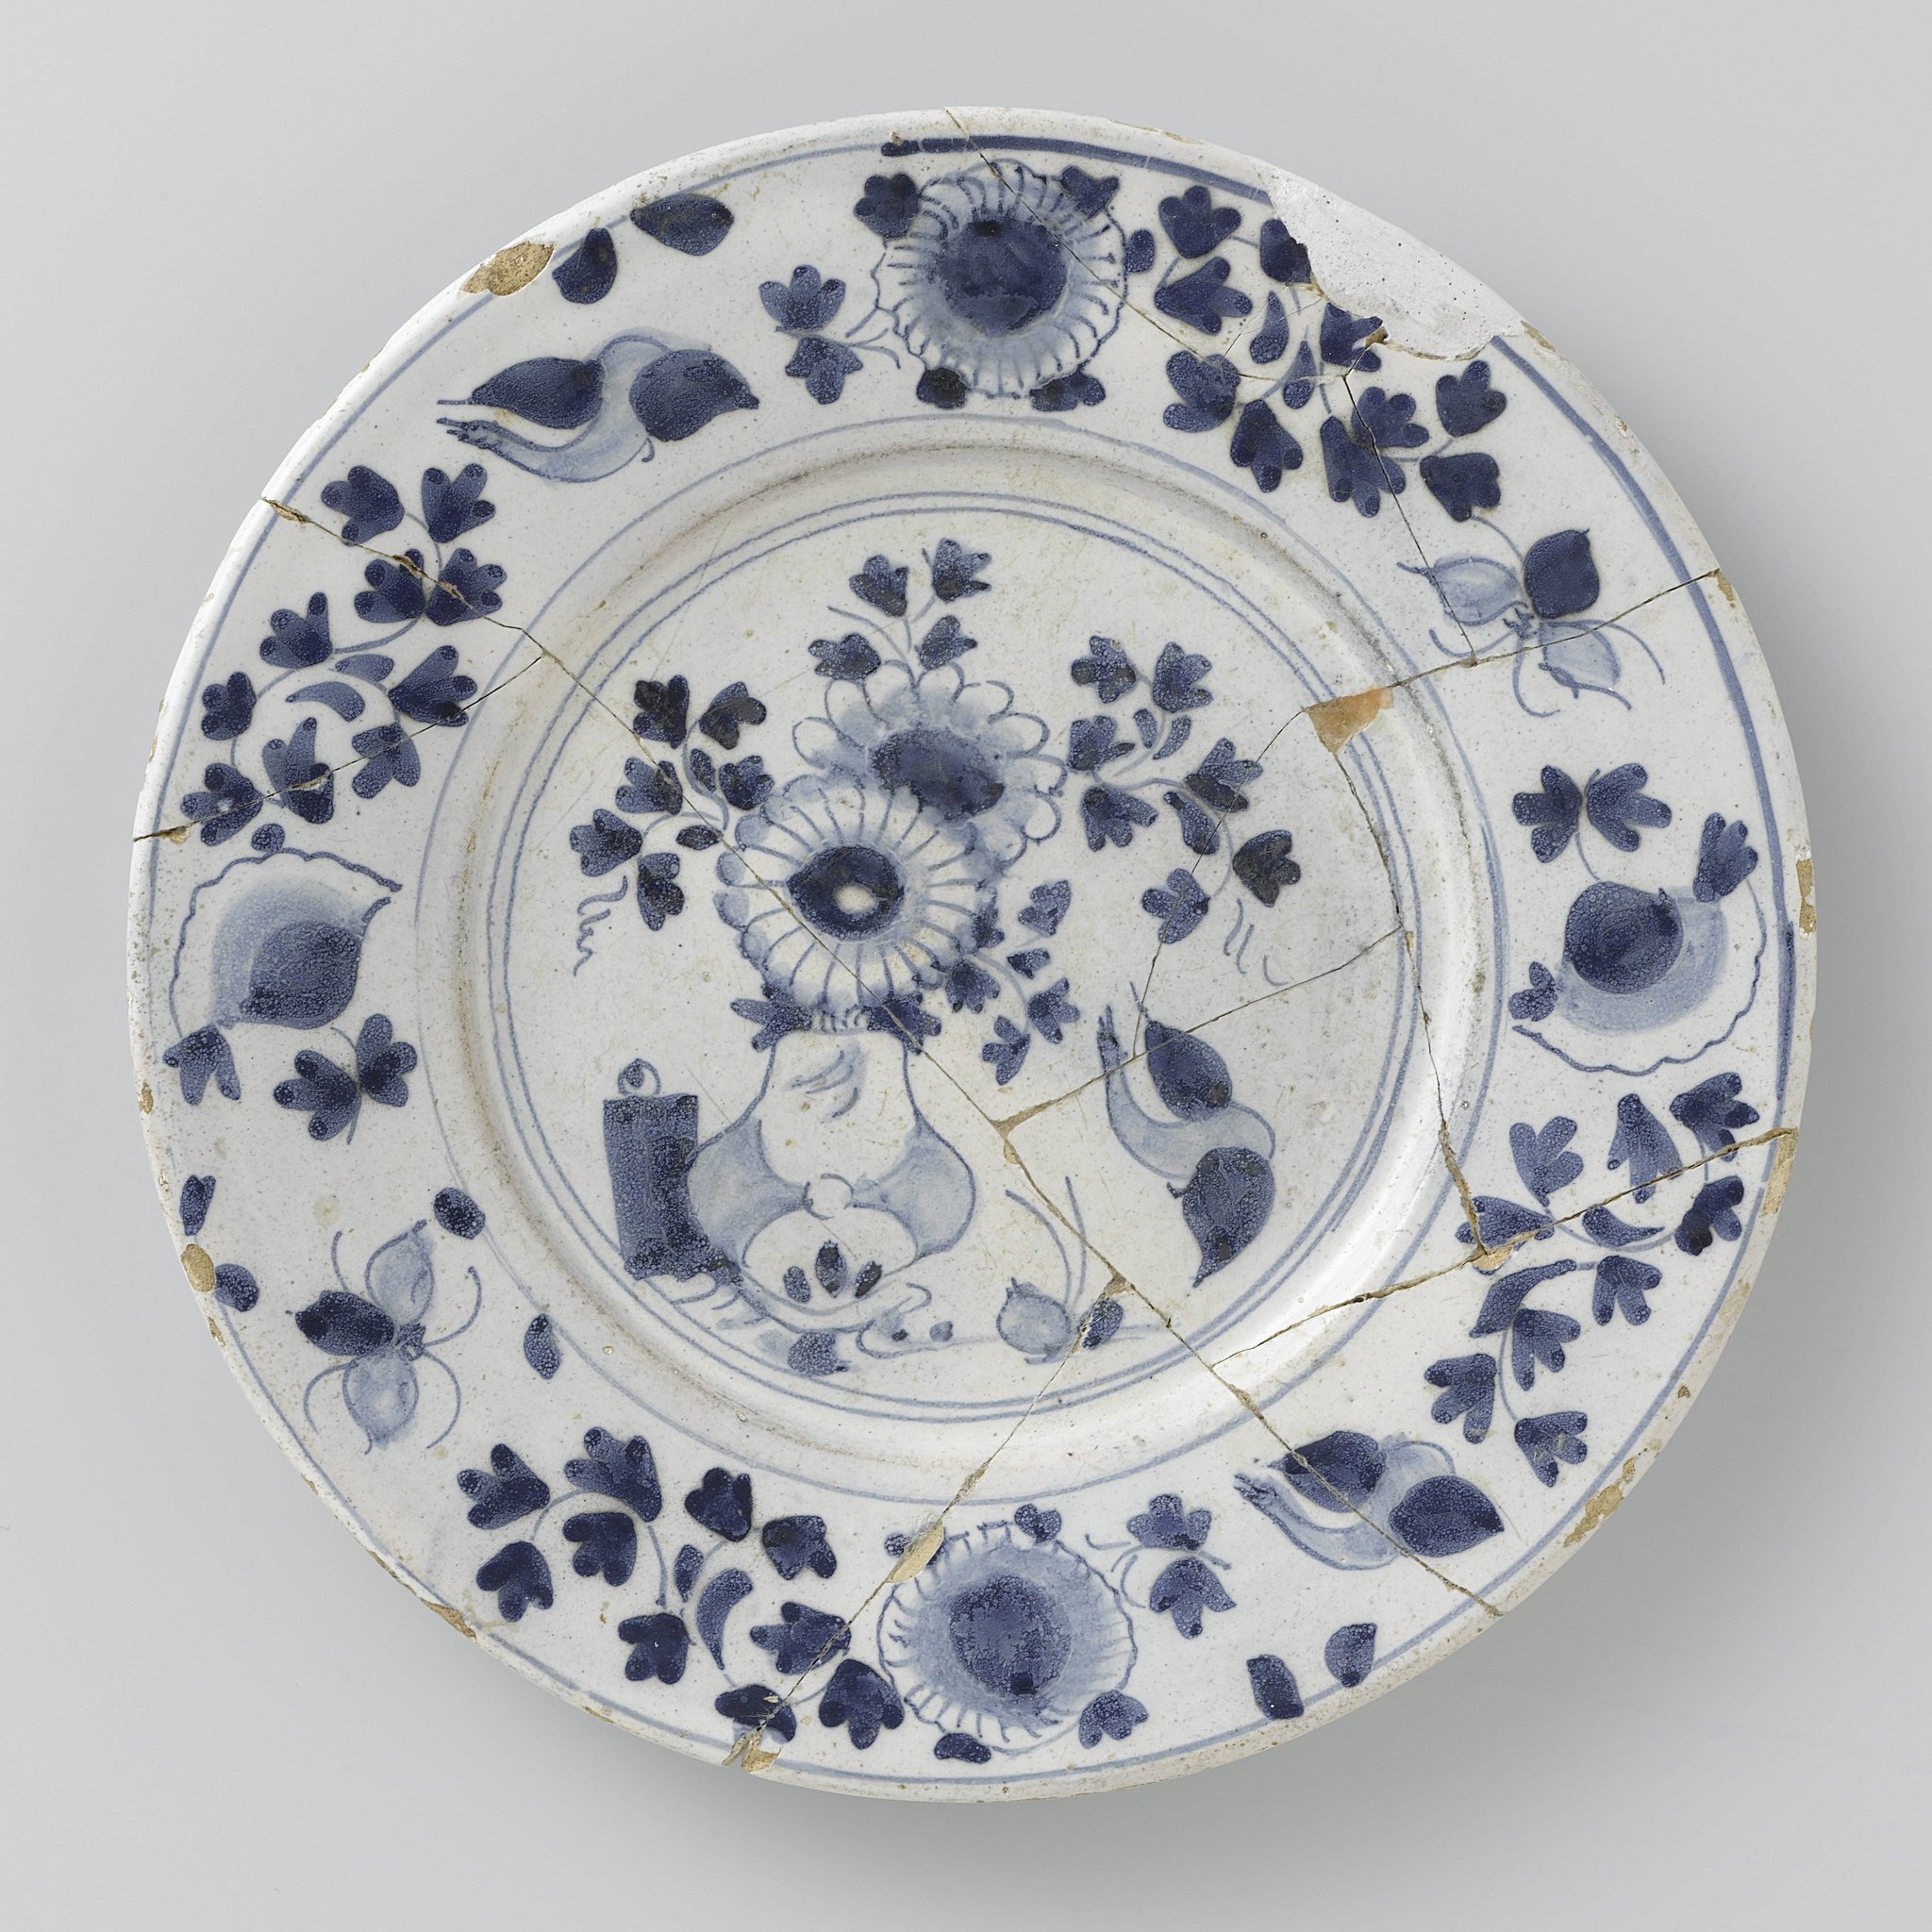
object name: plate dish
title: Bord met op het plat een vaas met bloemen en een vogel in blauw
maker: Anonymous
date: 1650-1670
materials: earthenware, glaze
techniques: painted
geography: delft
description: Rond bord van blauw beschilderde faience. Op het plat is een vaas met bloemen en een vogel geschilderd en op de rand bloemen, vogels en insekten. Het bord is een bodemvondst.